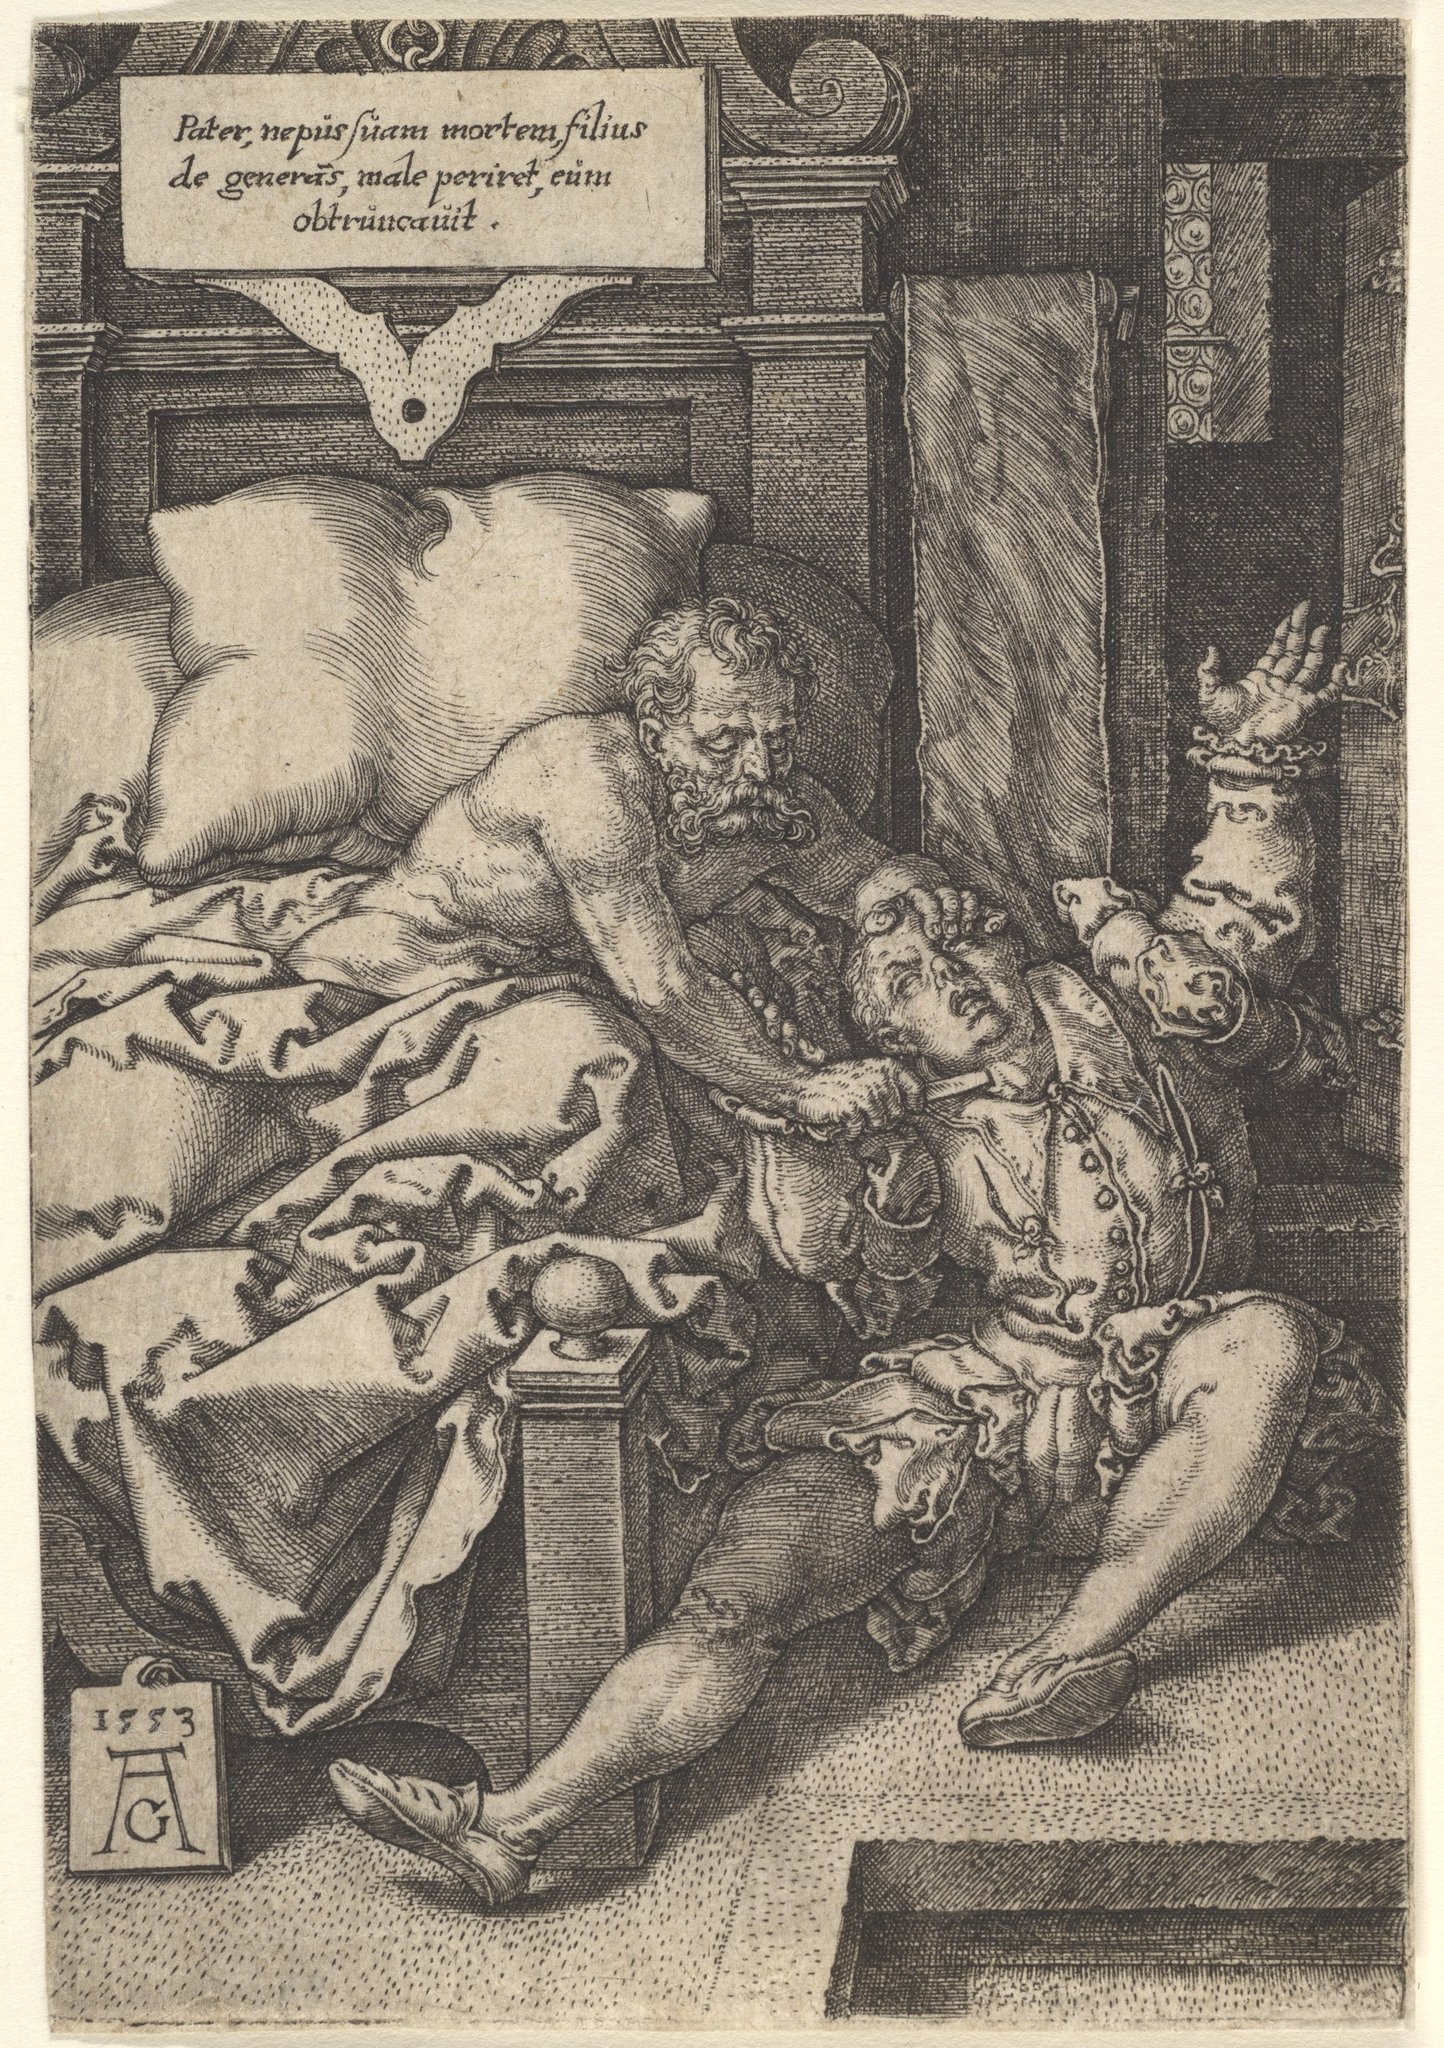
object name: print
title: Judge Herkinbald Cutting the Throat of his Nephew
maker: heinrich aldegrever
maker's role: artist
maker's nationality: german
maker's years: 1502-1561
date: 1553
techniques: engraving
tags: bedrooms,suffering,men